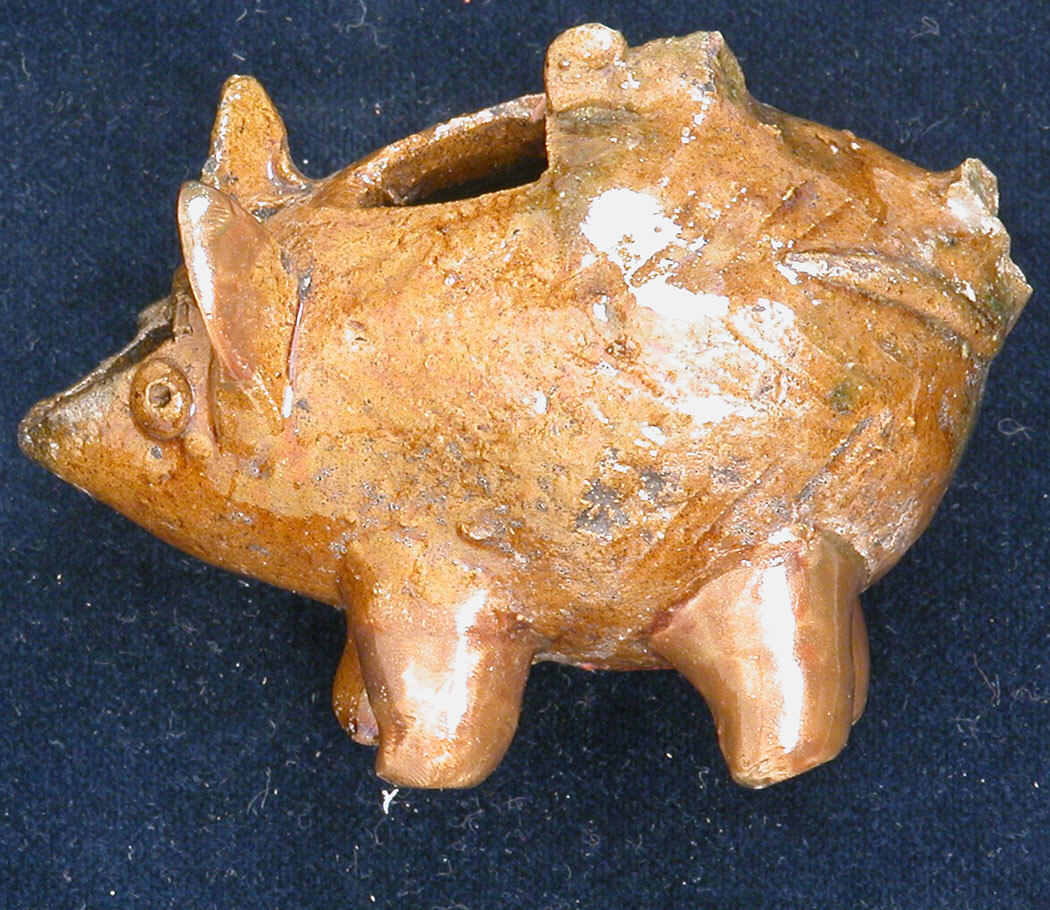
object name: lamp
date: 1334-1366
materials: earthenware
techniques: cutting, glazing, incising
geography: egypt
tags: animals